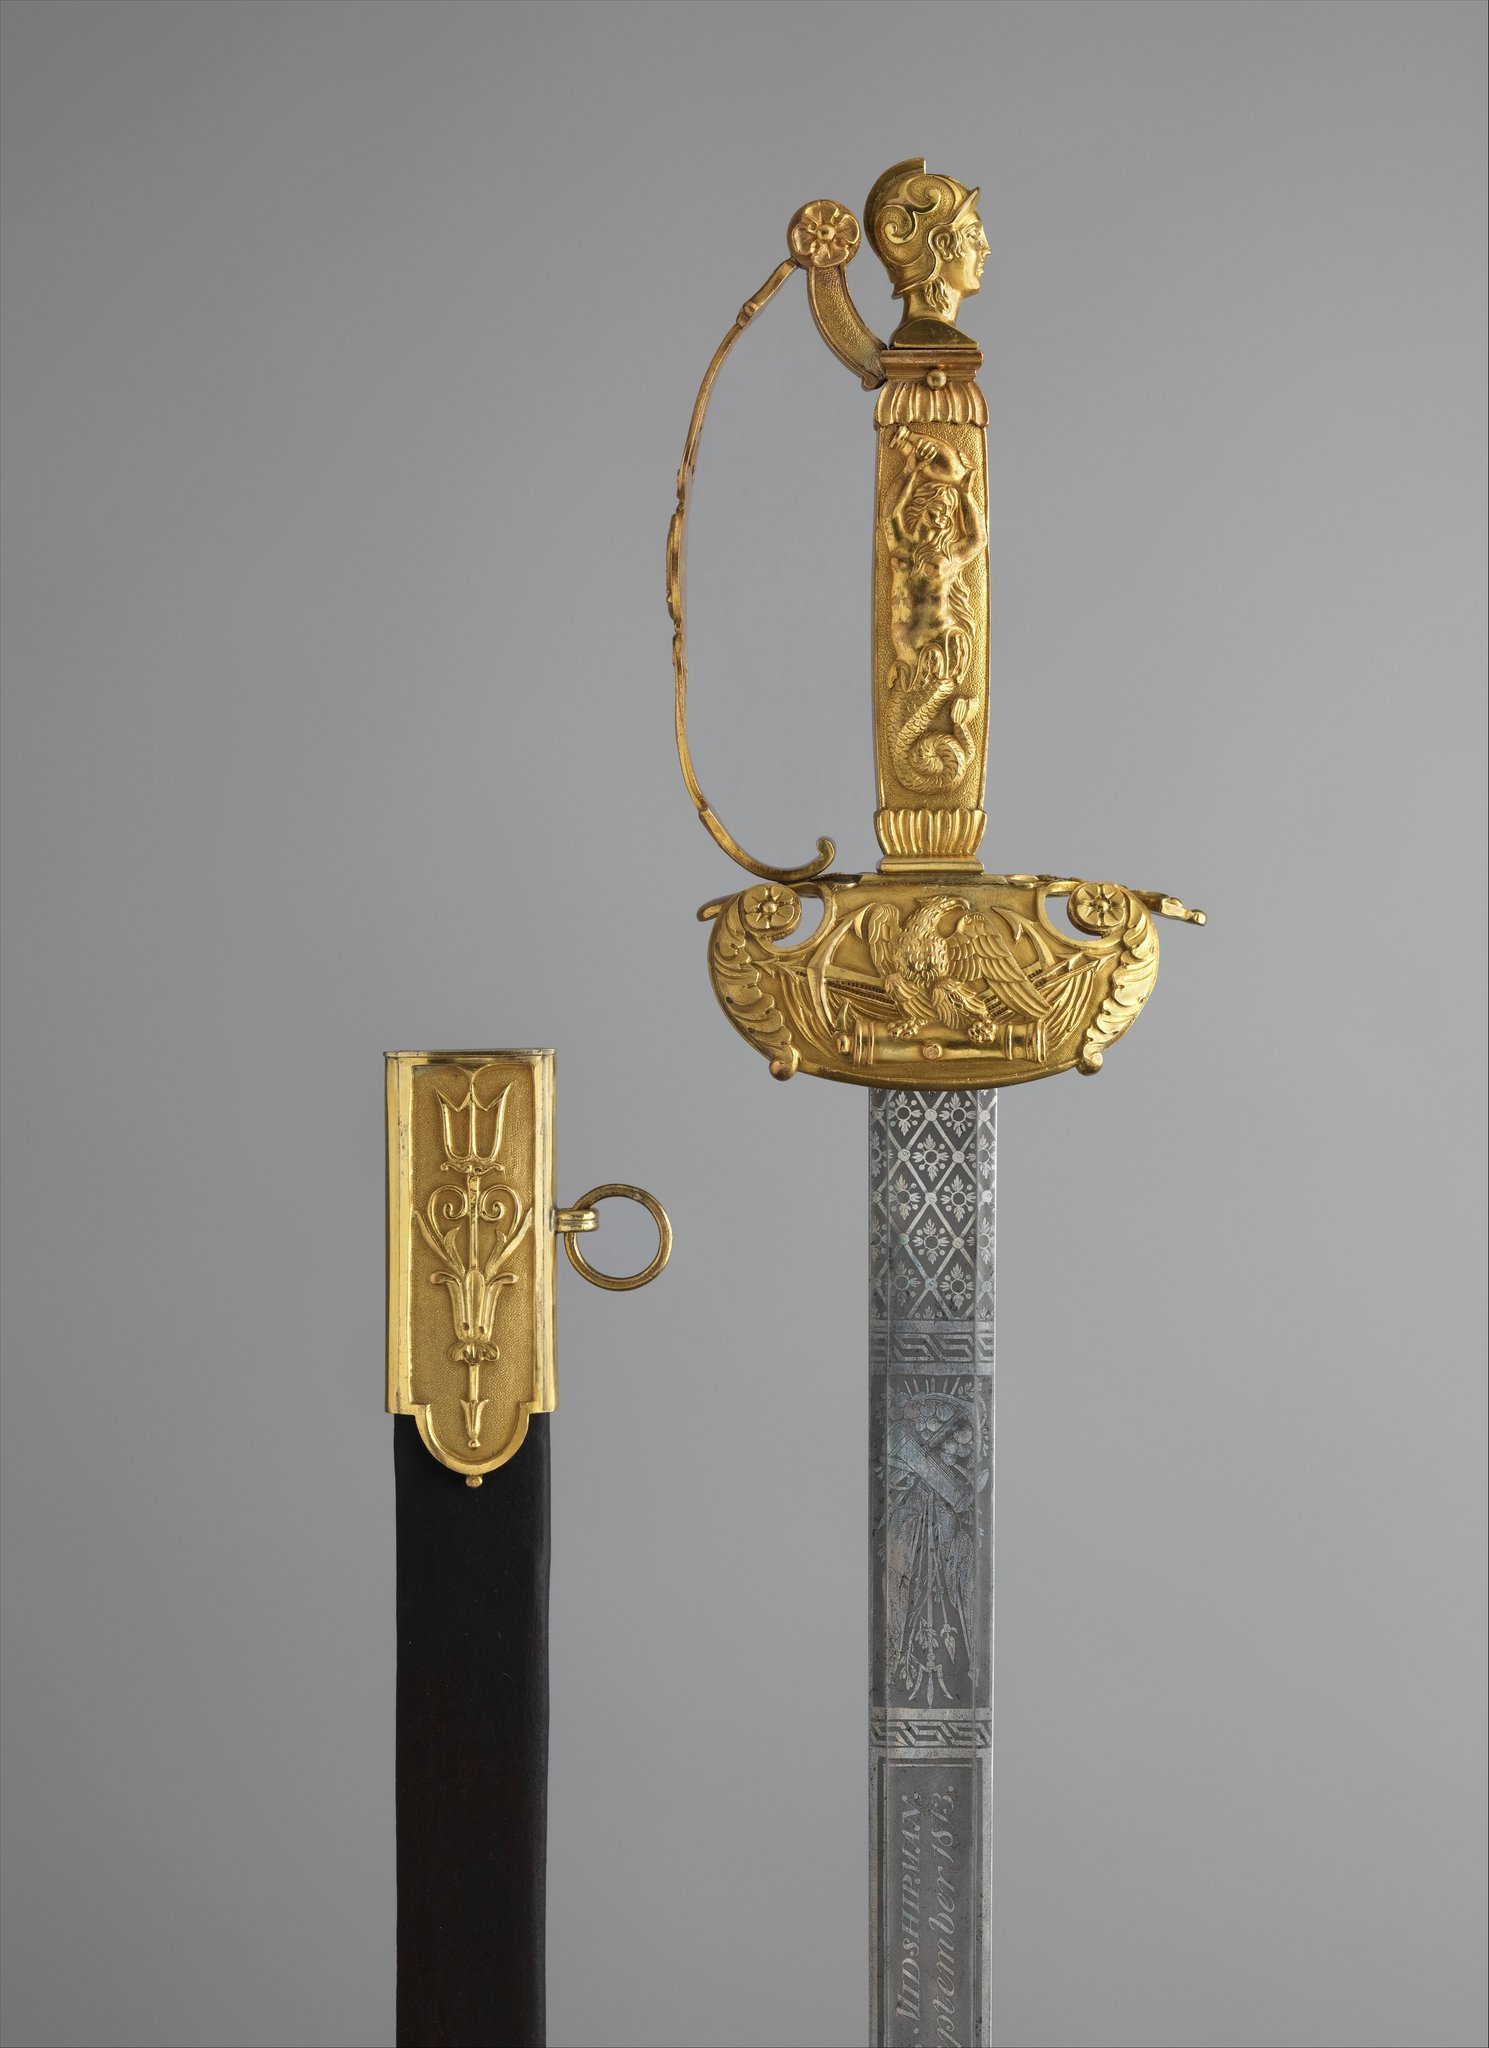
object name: presentation sword and scabbard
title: Congressional Presentation Sword and Scabbard of Peleg K. Dunham (1794–1822)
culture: american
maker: william rose sr., 1783–1856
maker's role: bladesmith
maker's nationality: american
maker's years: 1783-1856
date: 1817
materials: copper alloy, gold, leather, steel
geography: united states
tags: eagles,mermaids